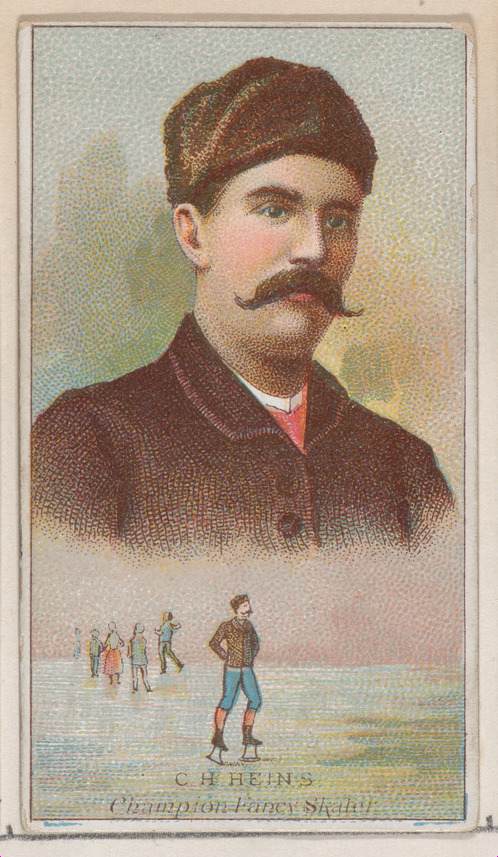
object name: print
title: C.H. Heins, Champion Fancy Skater, from the Champions of Games and Sports series (N184, Type 2) issued by W.S. Kimball & Co.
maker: w.s. kimball & co.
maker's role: publisher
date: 1887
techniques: color lithograph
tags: men,skating,athletes